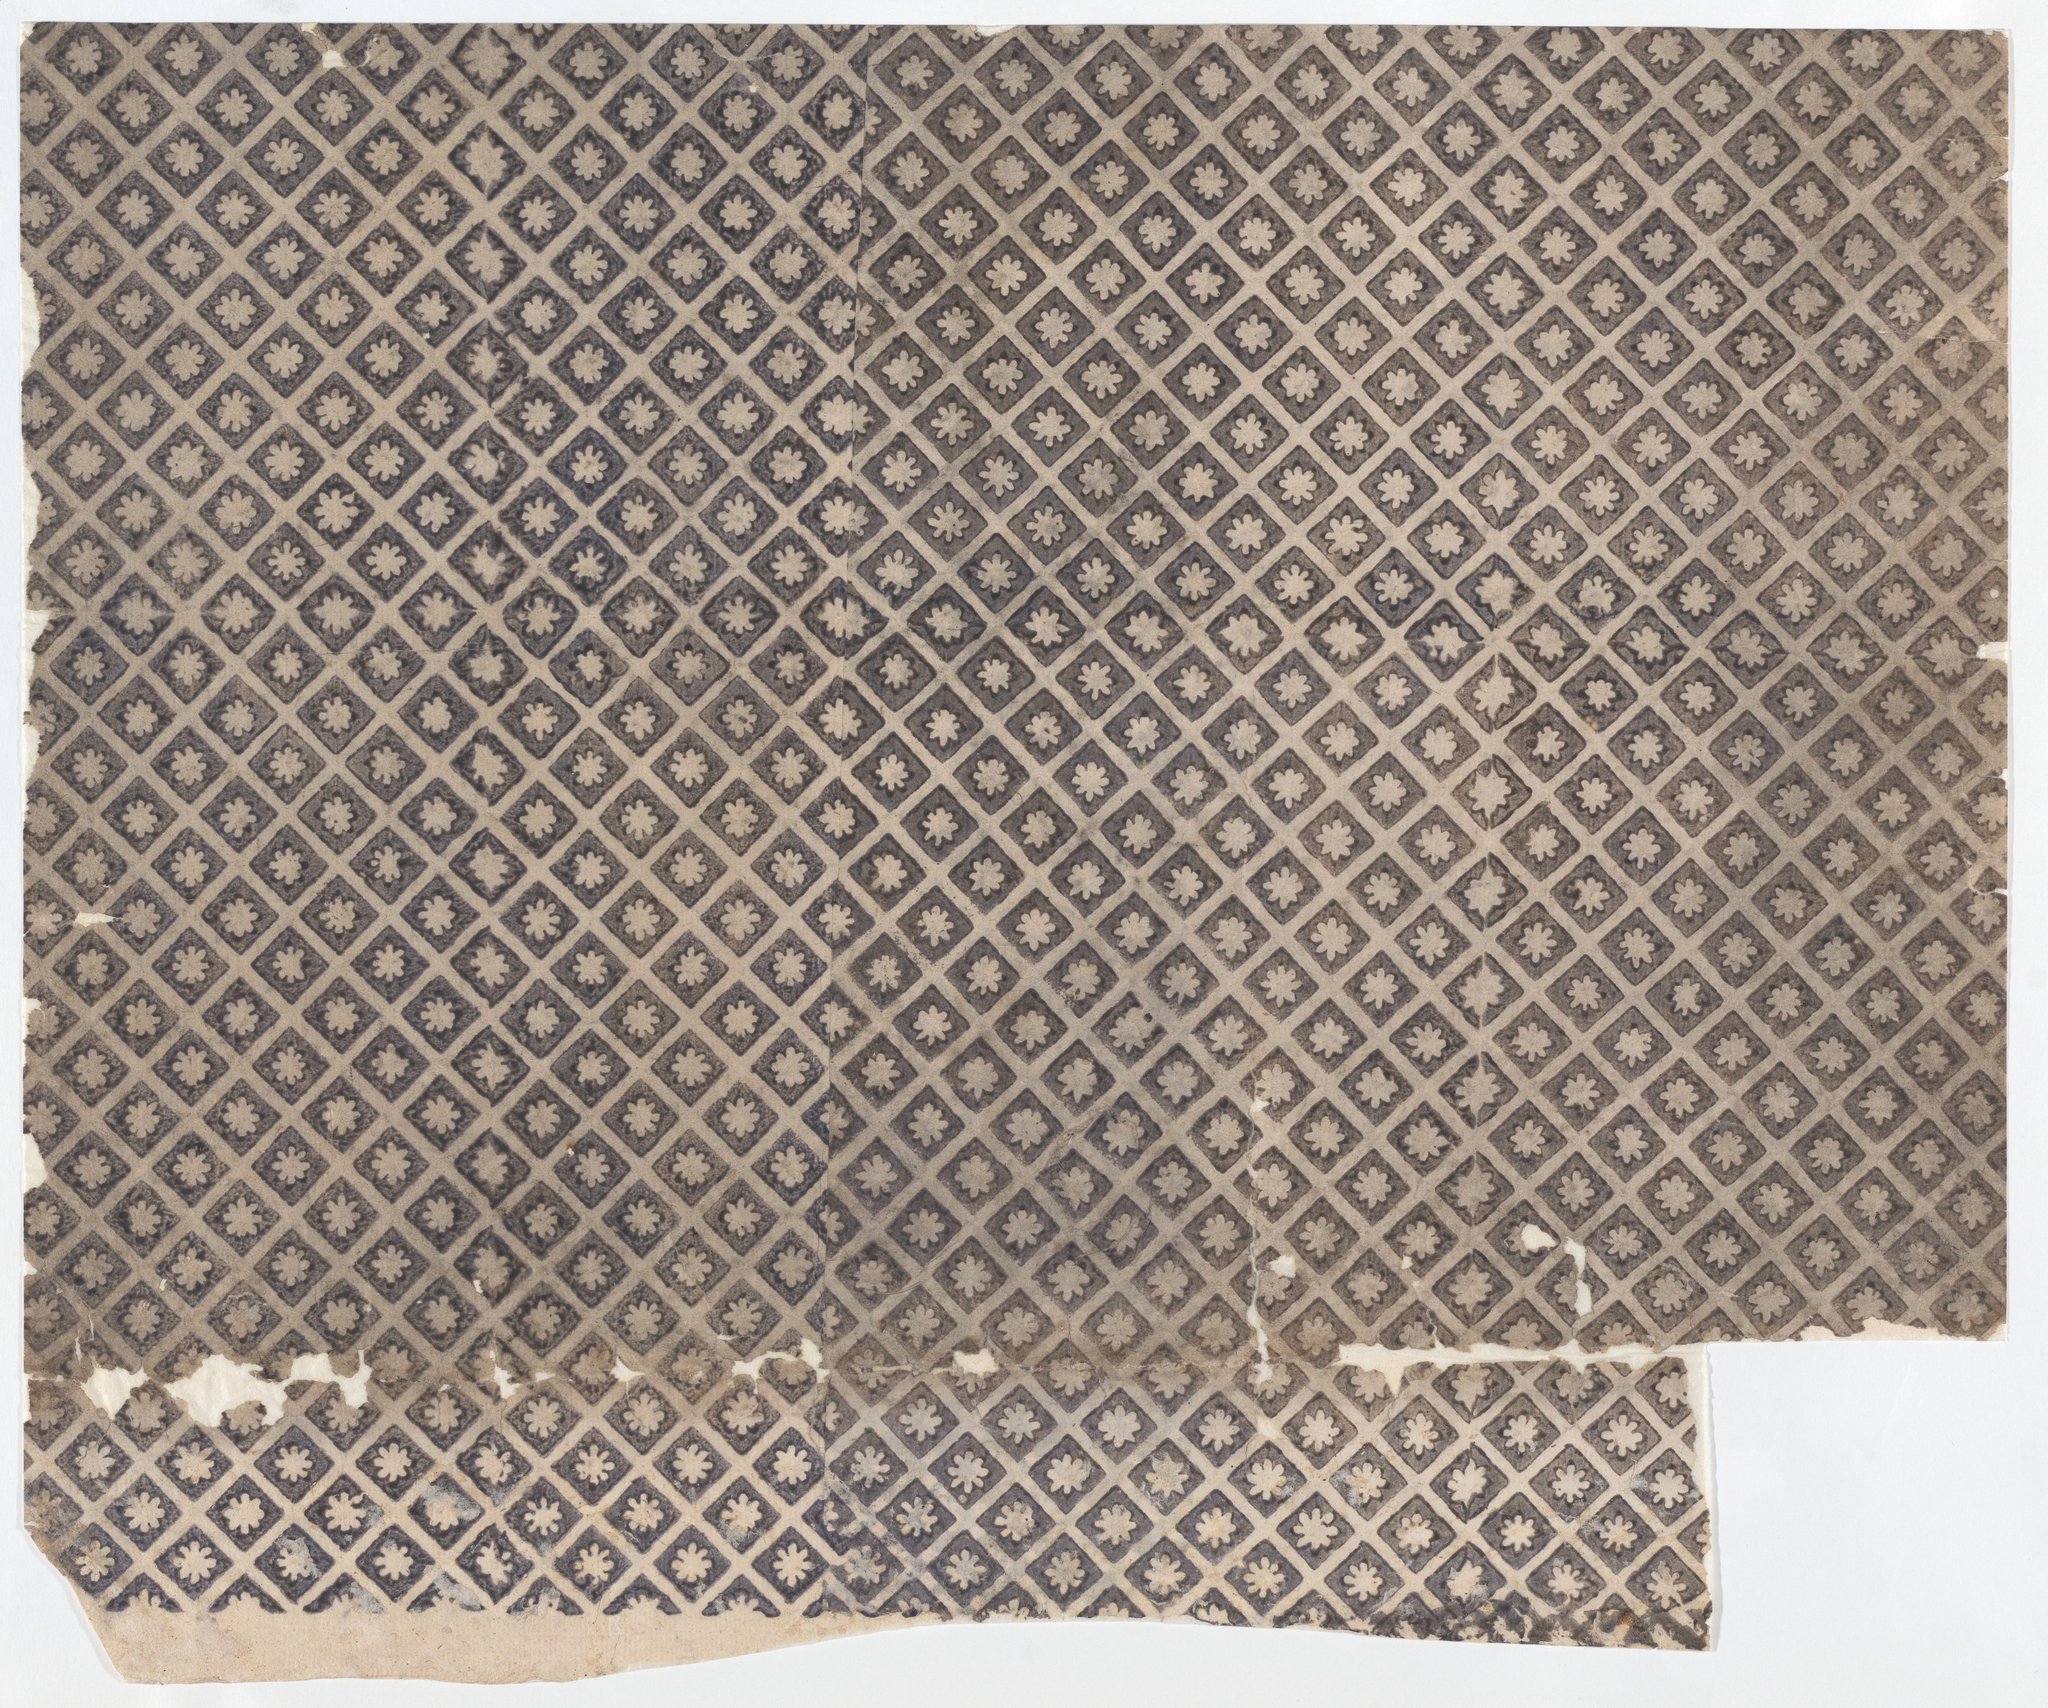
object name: print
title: Sheet with overall pattern of flowers within squares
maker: Anonymous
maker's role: artist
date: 1801-1900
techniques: relief print